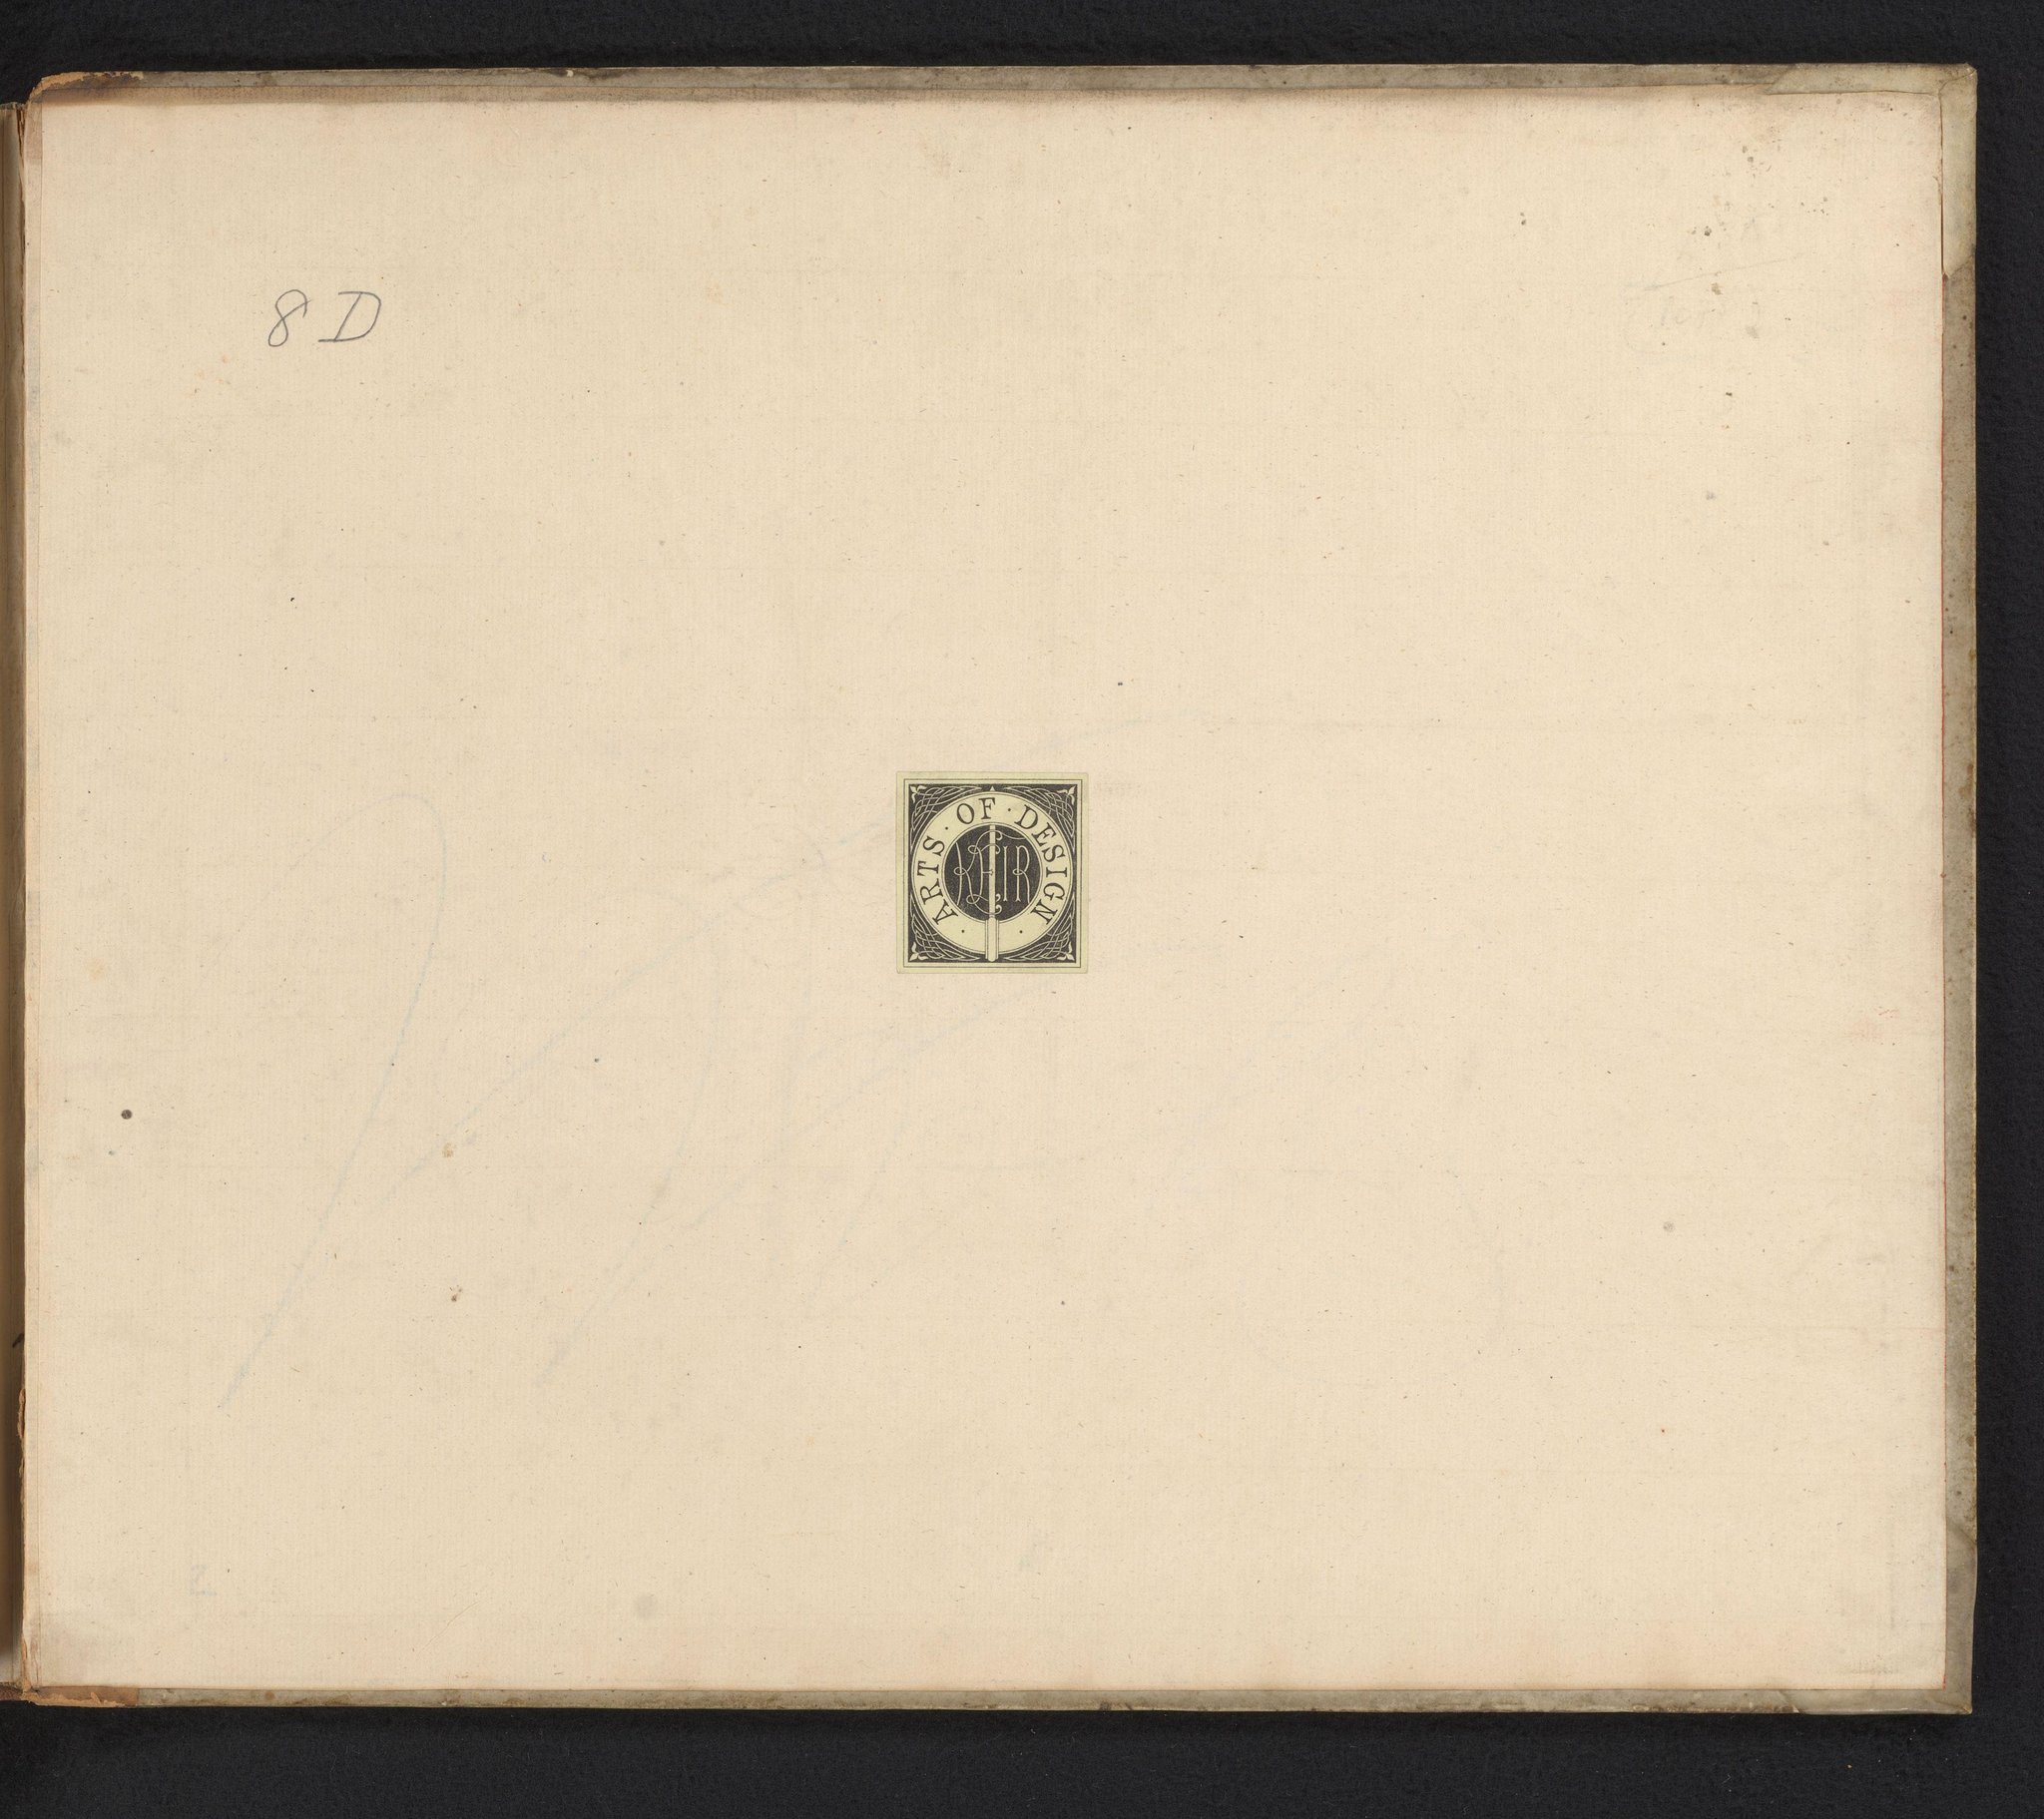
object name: pastedown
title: Ex libris uit de collectie van William Stirling Maxwell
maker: Anonymous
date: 1852-1878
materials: paper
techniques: etching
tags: politician, william stirling maxwell, ex-libris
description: Ex libris van William Stirling Maxwell. Dit label verwijst naar de 'Arts of Design' sectie in de bibliotheek van William Stirling Maxwell in zijn buitenhuis in Keir. Prent geplakt op het achterste dekblad van het album. Deze prent maakt deel uit van een album.